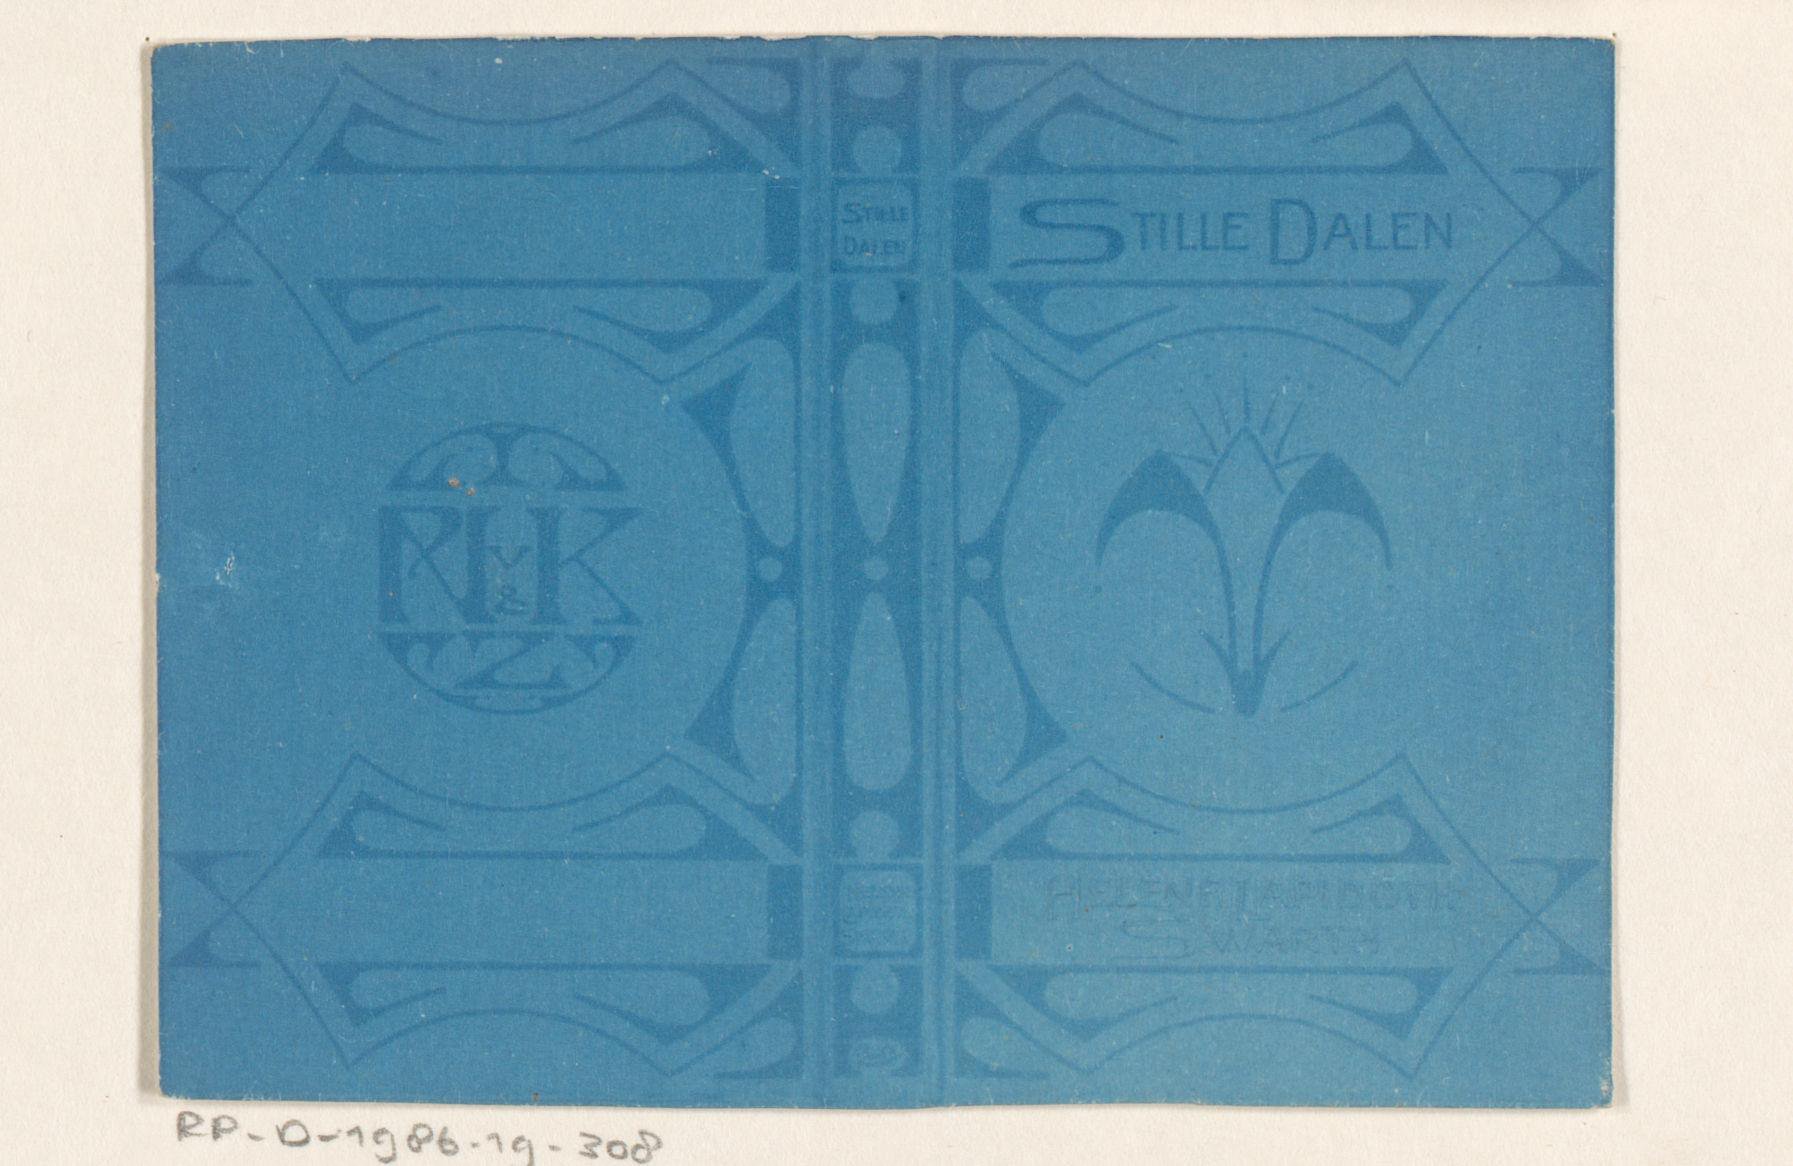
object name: photograph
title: Boekband van: Hélène Lapidoth-Swarth, Stille dalen, 1898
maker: Anonymous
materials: photographic support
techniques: cyanotype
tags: book-cover, binding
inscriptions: collector's mark: ‘R:MVS.’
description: Lapidoth-Swarth, Hélène. Stille dalen. Amsterdam: Van Kampen, 1898.